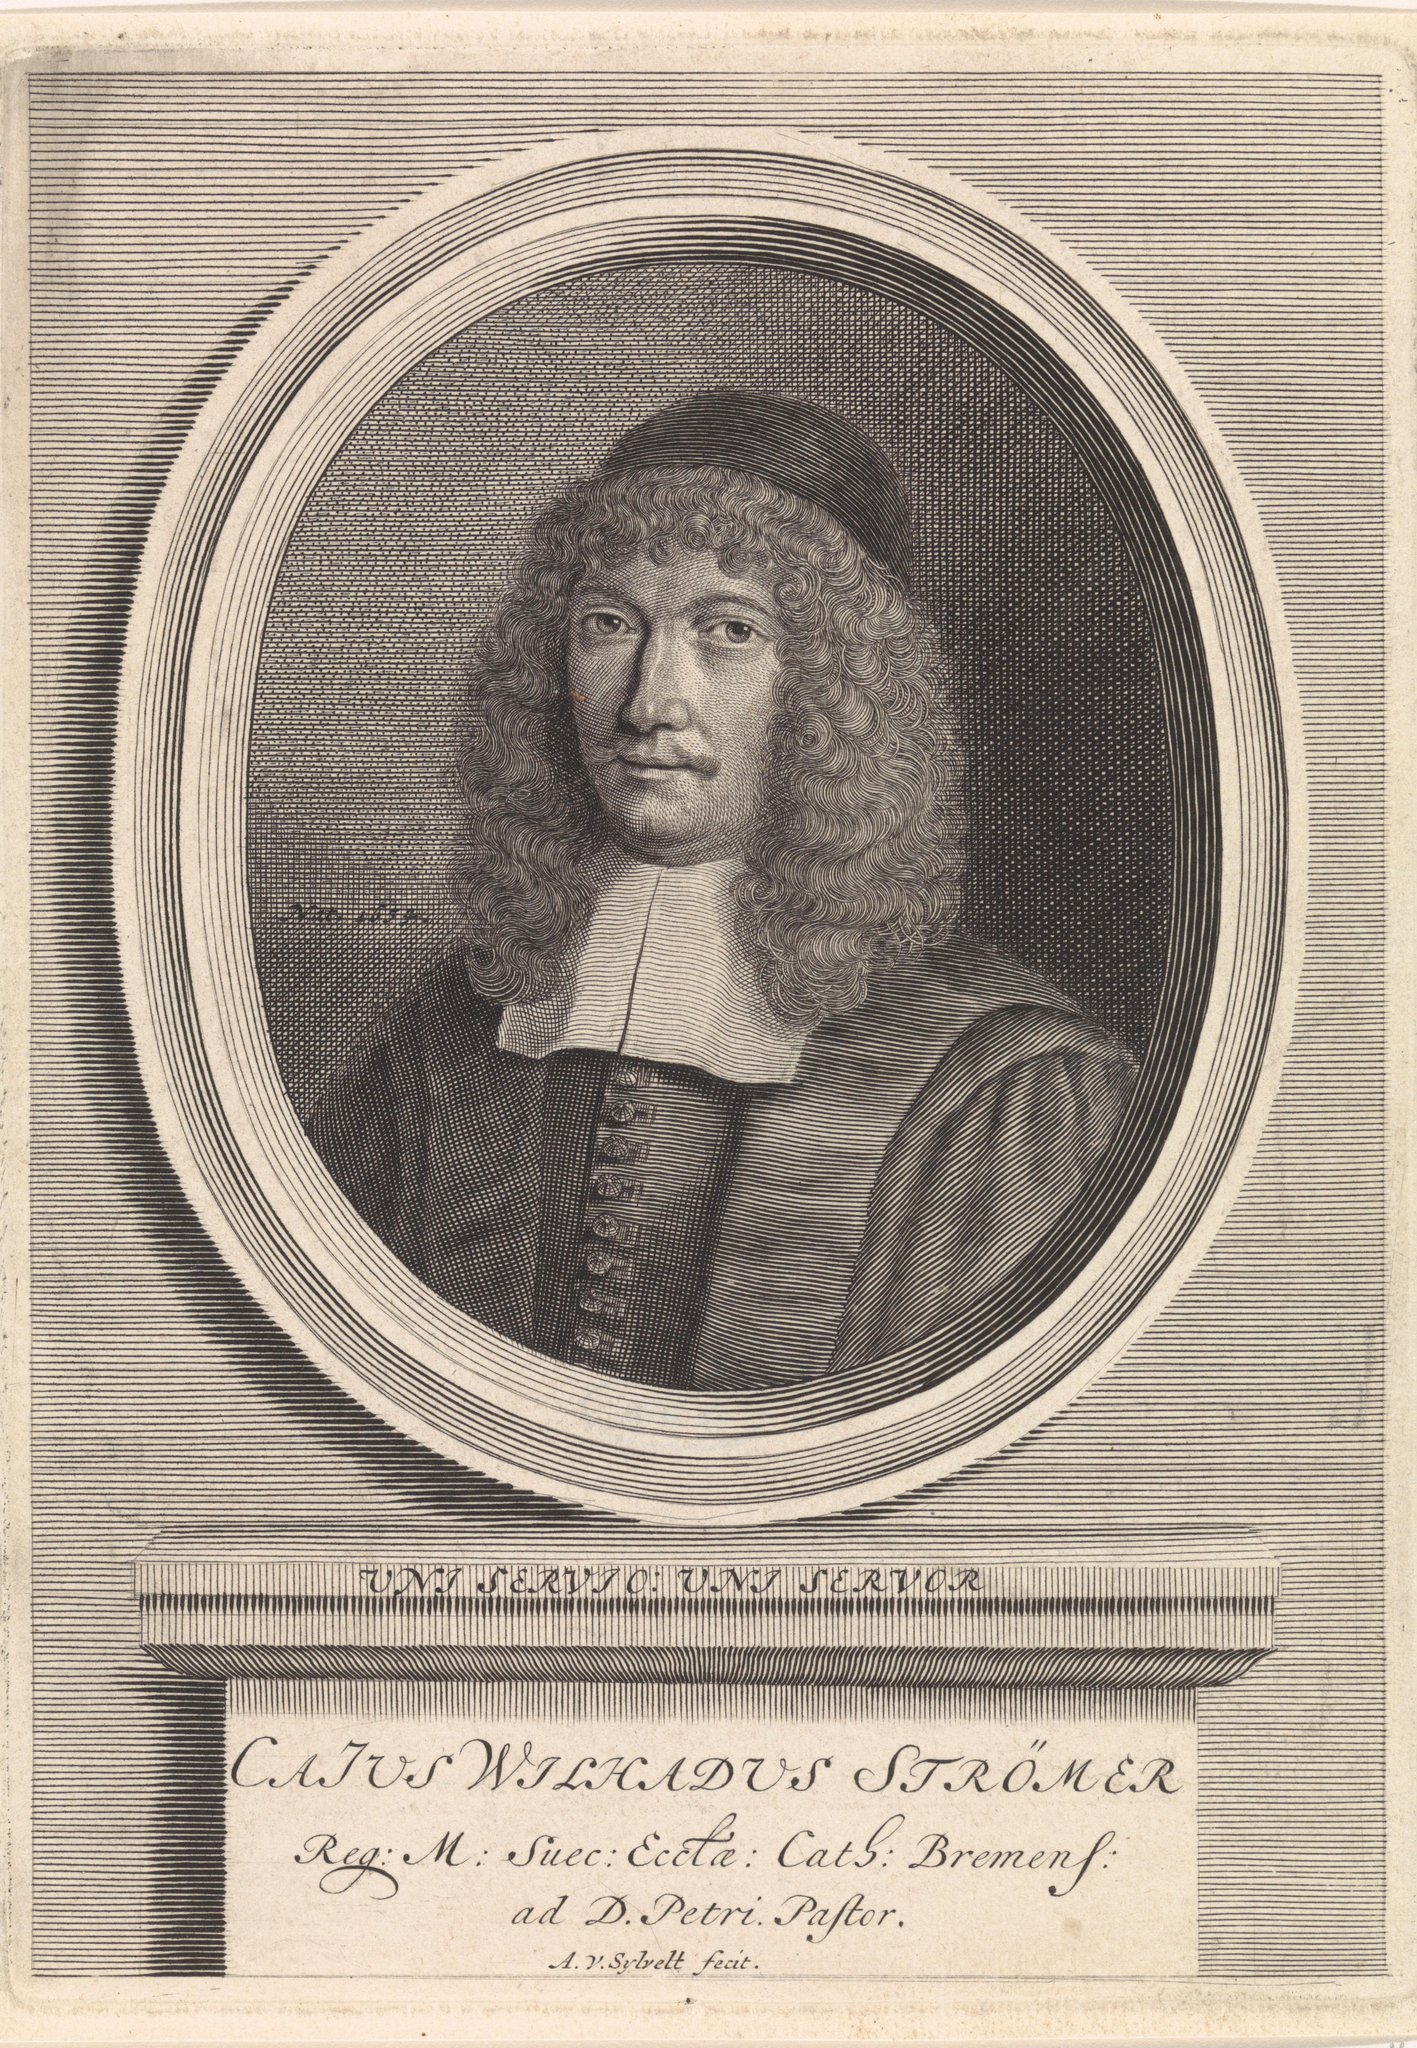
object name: print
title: Portret van Cajus Wilhad Strömer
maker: anthony van zijlvelt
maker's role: print maker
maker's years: 1637-1715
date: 1674-1695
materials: paper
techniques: engraving, etching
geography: amsterdam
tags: predikant, theoloog, cajus wilhad strömer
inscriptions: collector's mark: Lugt 2228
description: Portret van Cajus Wilhad Strömer, pastoor en theoloog te Bremen.